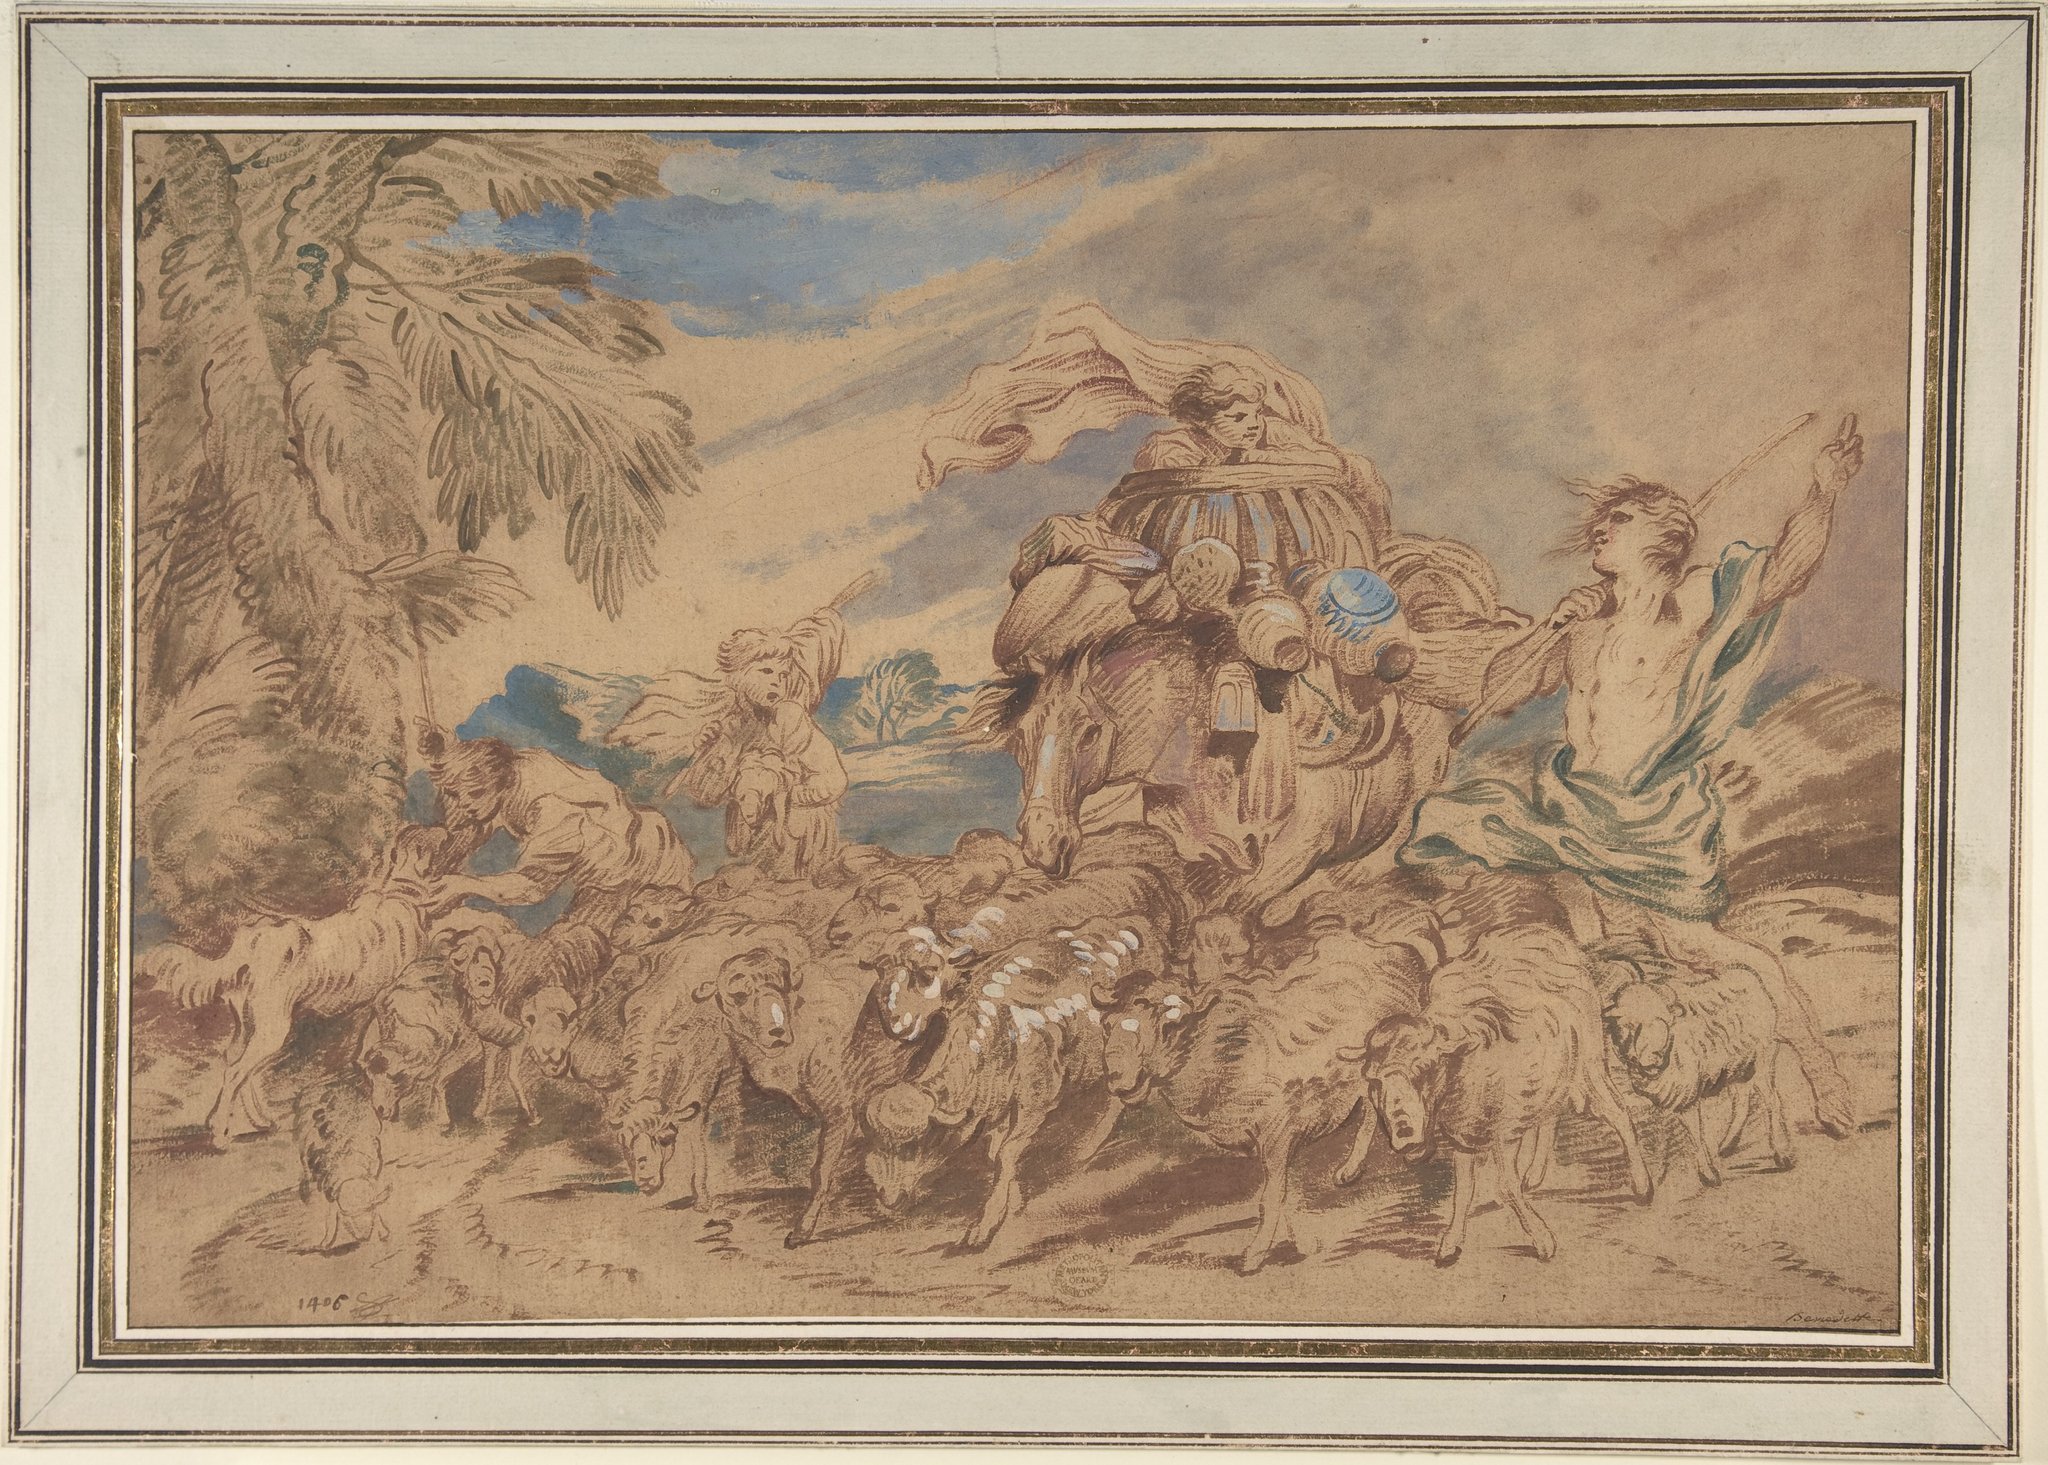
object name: drawing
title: Pastoral Scene: Shepherds and Their Flock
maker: michel corneille the younger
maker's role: artist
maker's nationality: french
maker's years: 1642-1708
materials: paint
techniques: brush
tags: men,sheep,shepherds